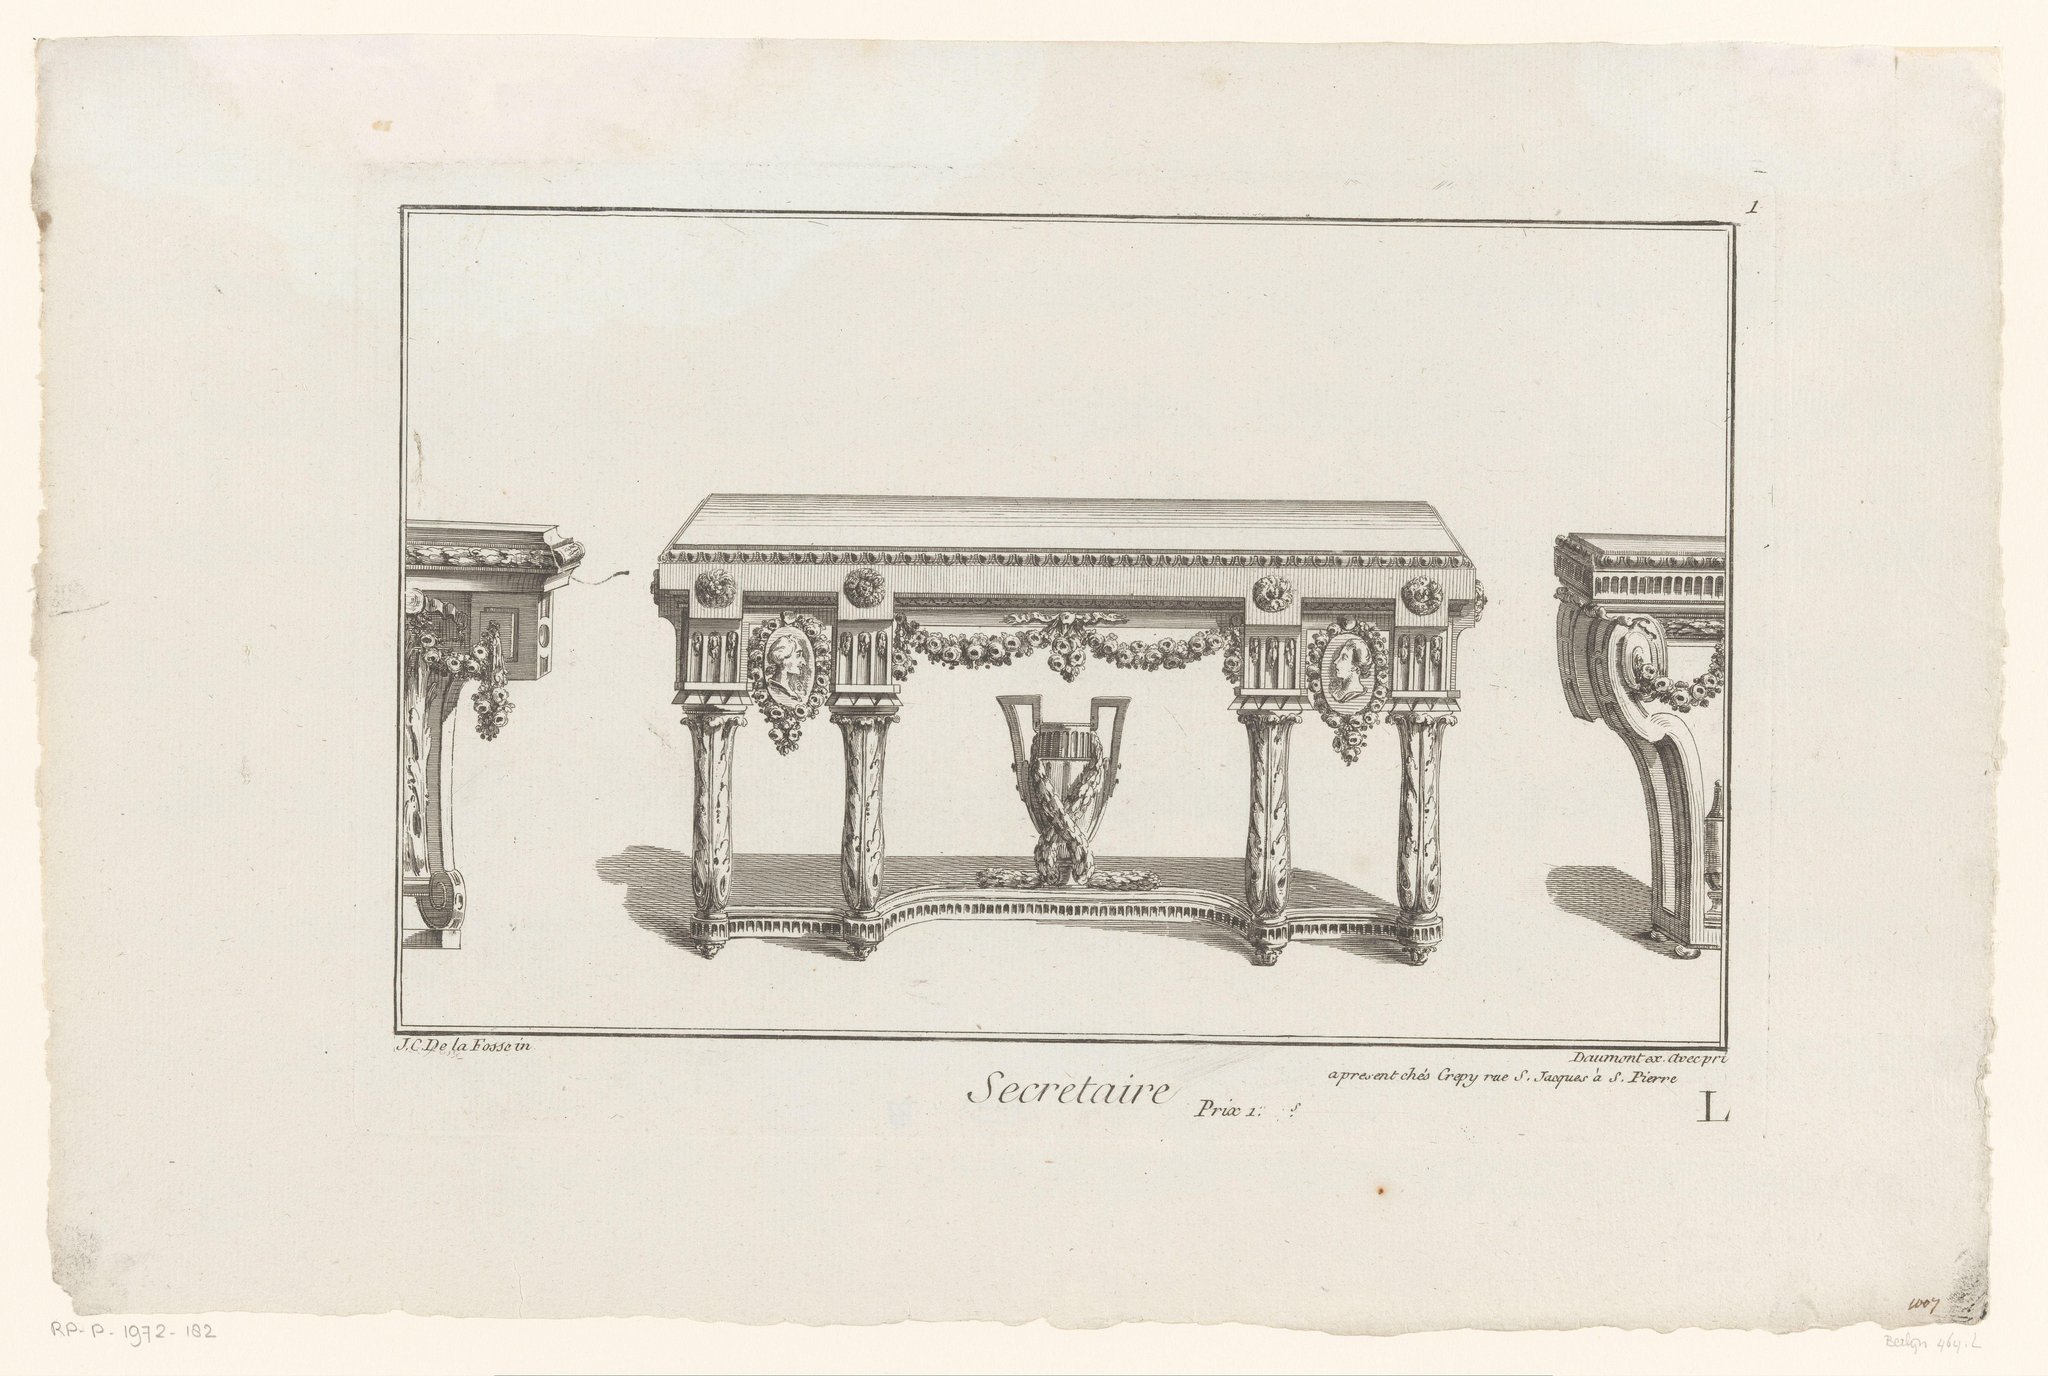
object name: print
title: L Tafels en cul-de-lampes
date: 1745-1775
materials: paper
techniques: engraving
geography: paris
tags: writing-table, writing-desk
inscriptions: collector's mark: Lugt 2760, collector's mark: Lugt 2228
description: Een (schrijf)tafel met guirlandes, twee medaillons met portretten en een vaas.